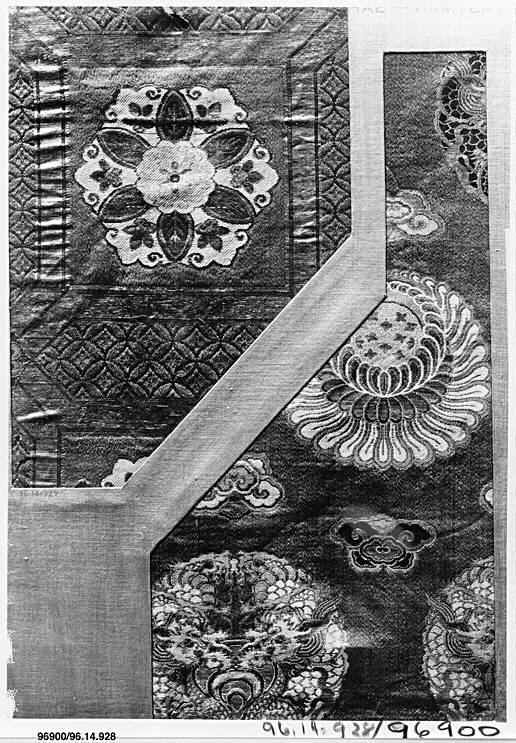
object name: piece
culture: japanese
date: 1701-1800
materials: metal thread, silk